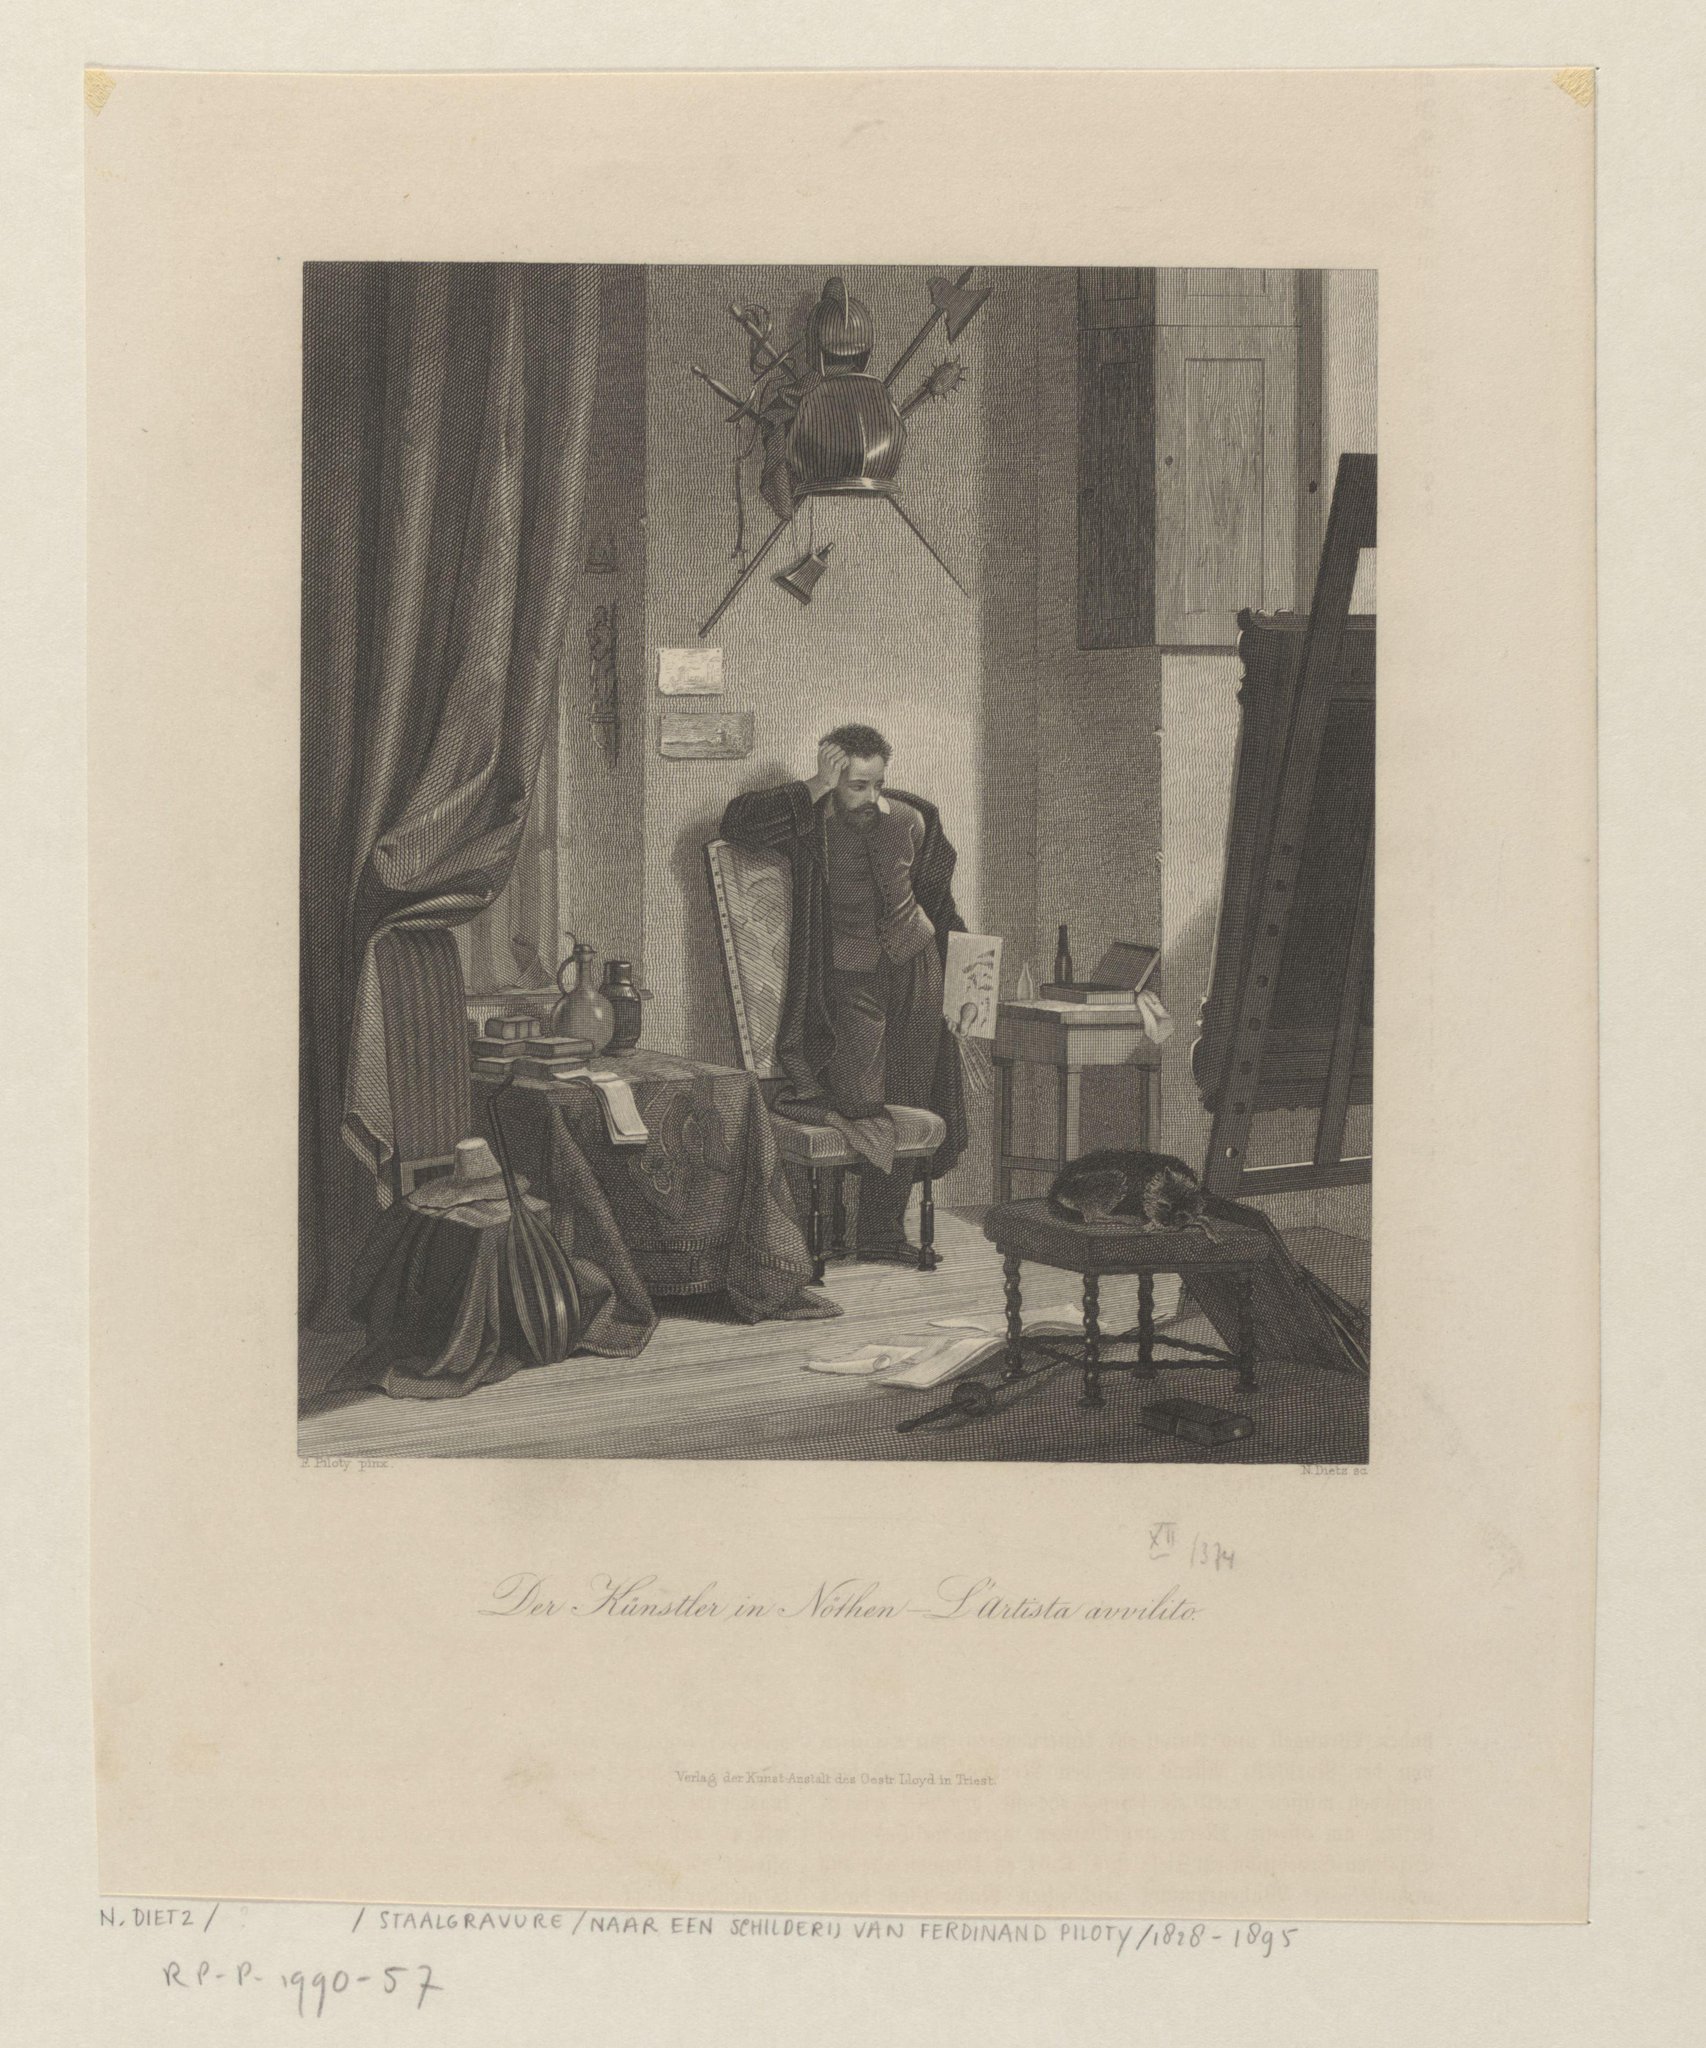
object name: print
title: Peinzende kunstenaar in zijn atelier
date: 1838-1899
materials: paper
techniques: engraving, etching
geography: trieste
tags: painter at work, in his studio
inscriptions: number: ‘1857(248)’, number: ‘719/64’, number: ‘1410’, collector's mark: Lugt 2228